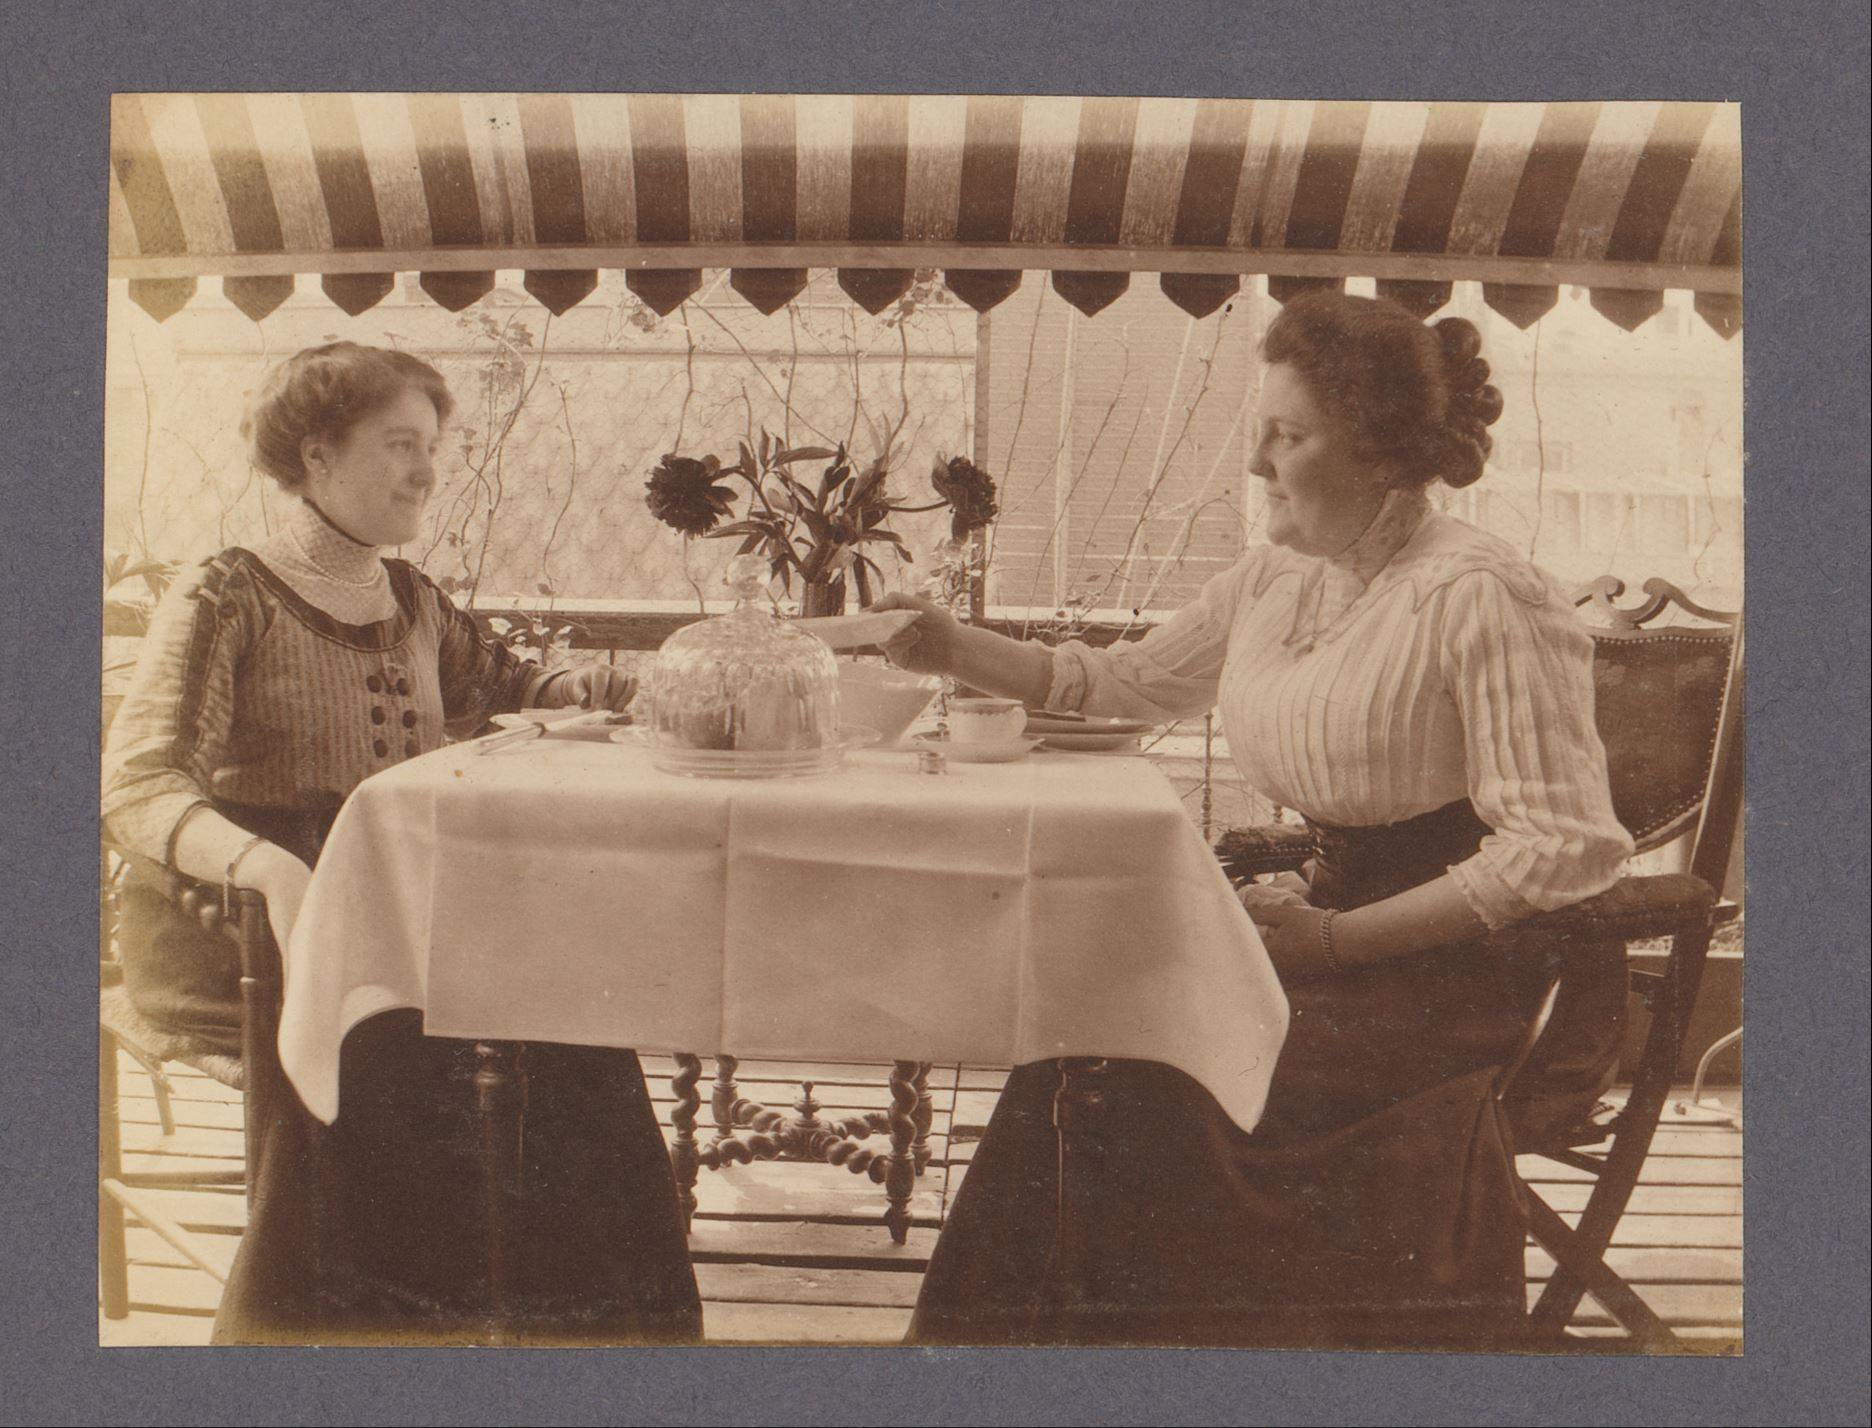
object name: photograph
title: Tine Vermeulen en een andere vrouw op een terras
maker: cornelis johannes lodewicus vermeulen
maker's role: fotograaf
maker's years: 1861-1936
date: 1900-1925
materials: photographic support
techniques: gelatin silver print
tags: adult woman